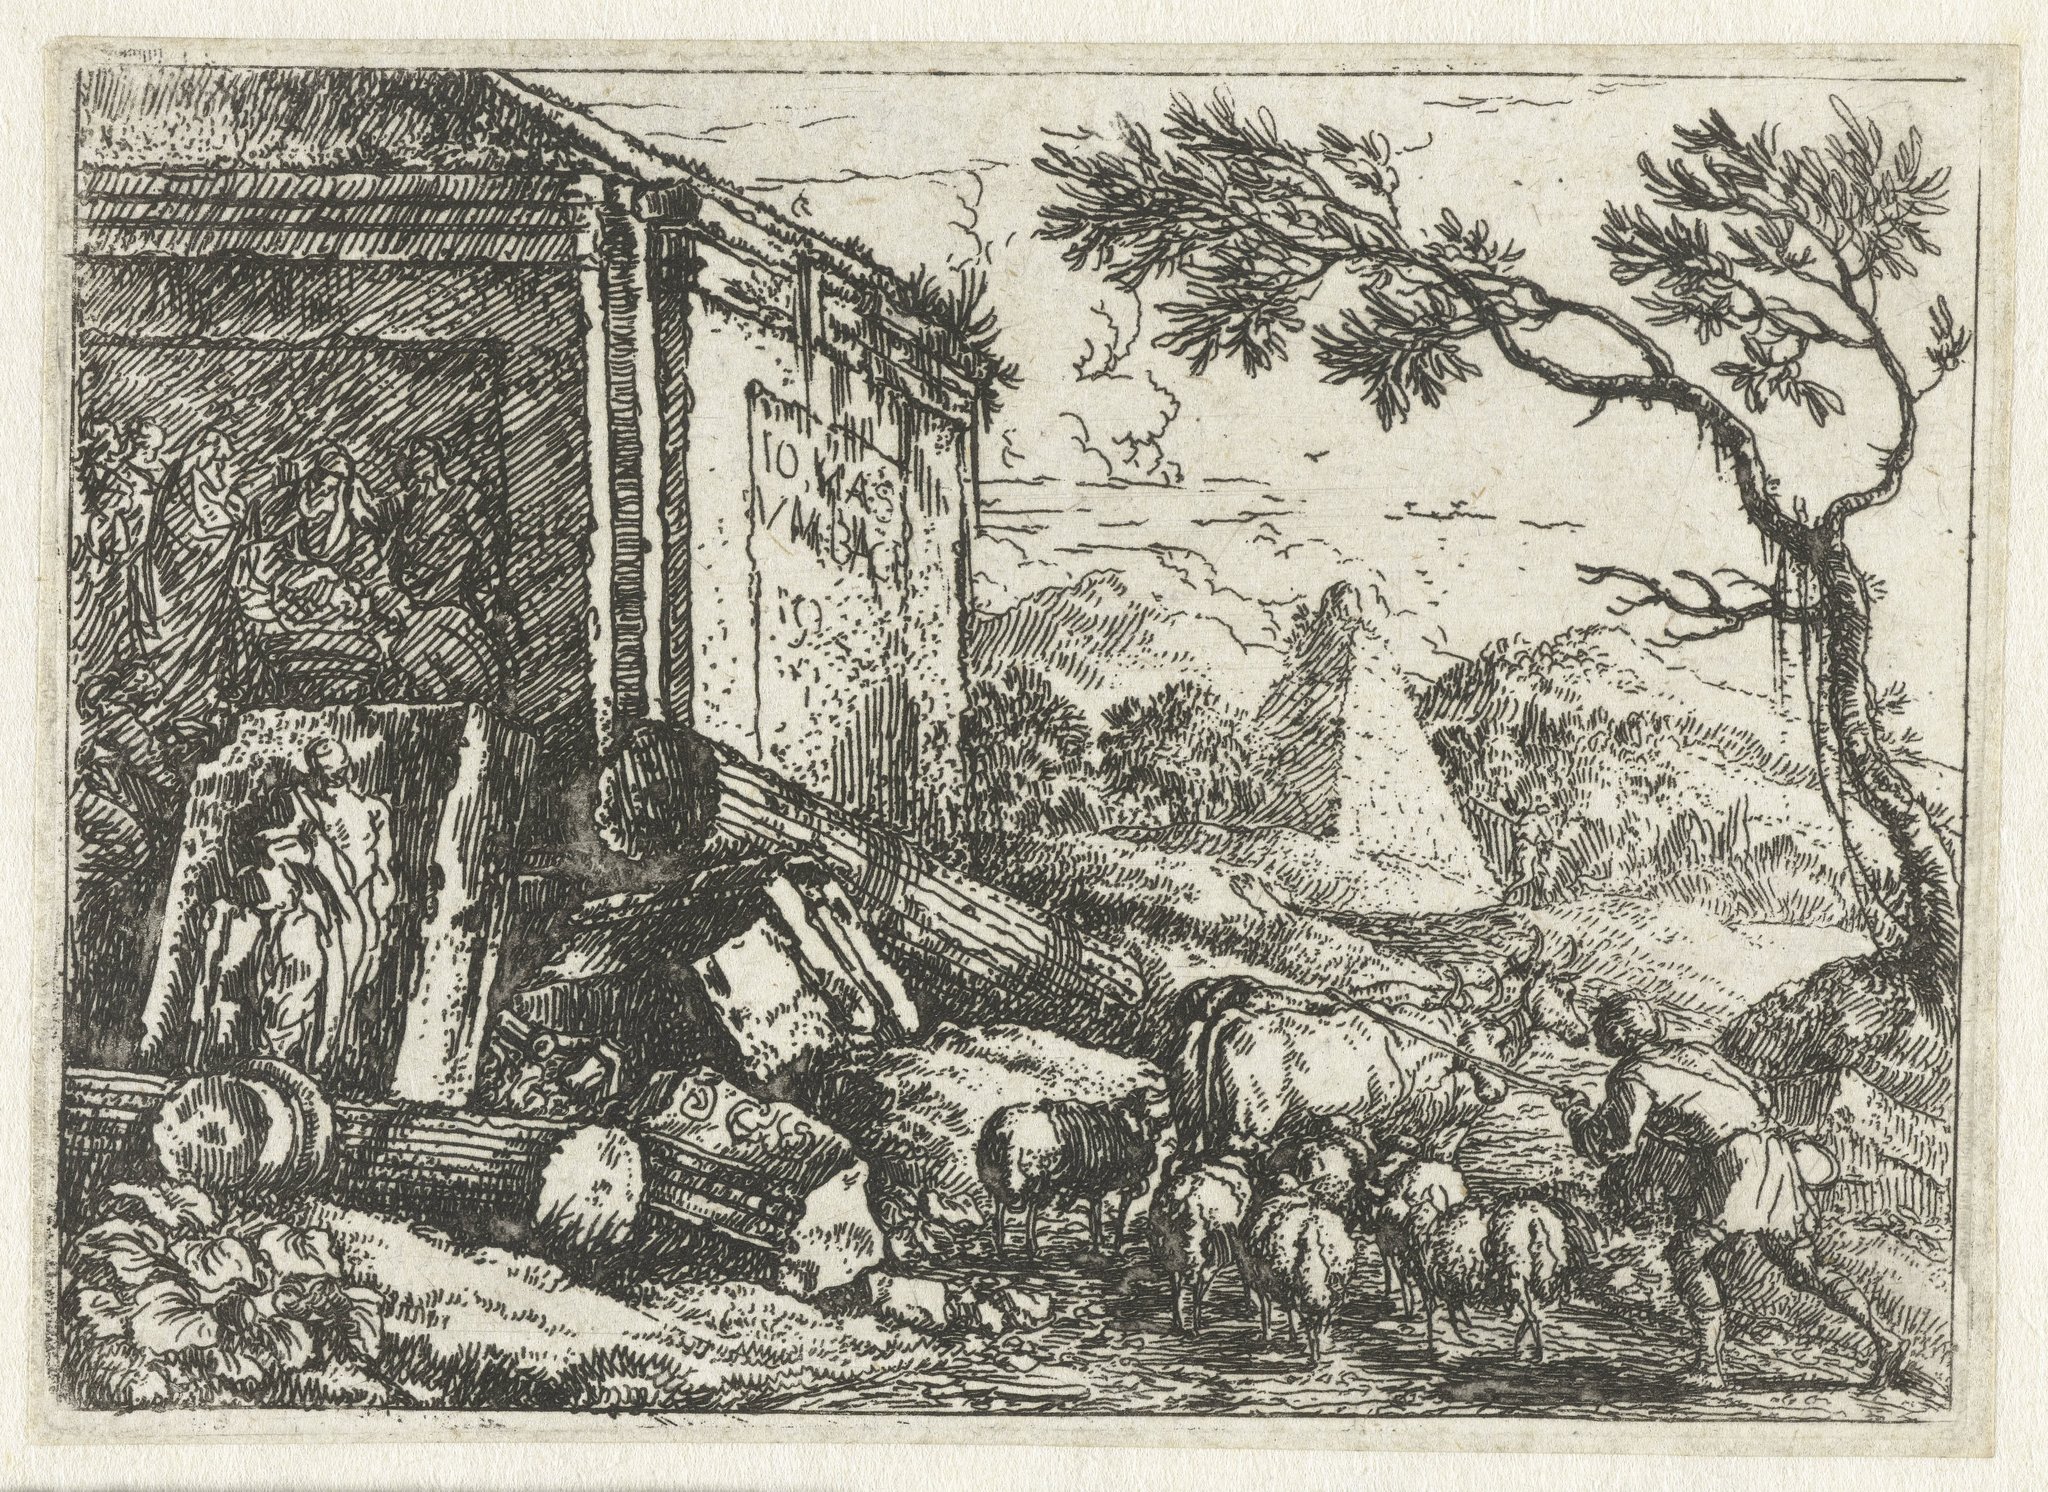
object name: print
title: Ruïnelandschap met een herder en zijn kudde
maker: jonas umbach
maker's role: print maker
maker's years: 1624-1693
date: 1634-1693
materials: paper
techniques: etching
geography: augsburg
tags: herding, herdsman, herdswoman, shepherd, shepherdess, cowherd, etc., landscape with ruins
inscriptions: collector's mark: Lugt 240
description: Landschap met ruïnes. Links te midden van losse zuilen en brokstukken, een sarcofaag met een reliëf. Over de weg loopt een herder met een kudde schapen en koeien.